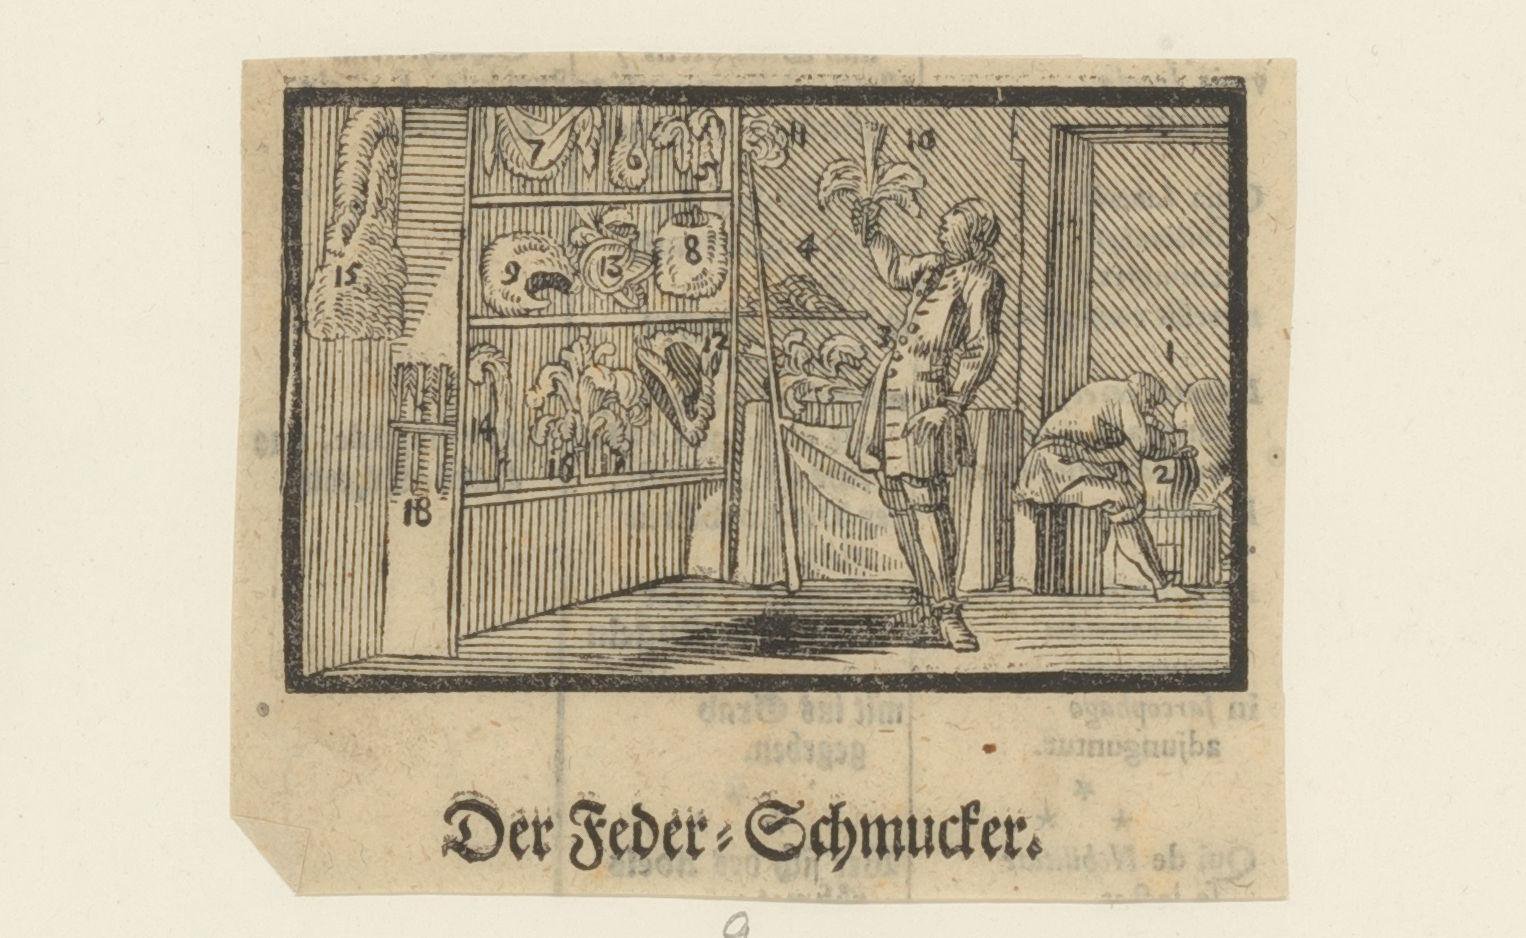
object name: print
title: Winkel voor veren en sieraden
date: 1719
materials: paper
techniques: letterpress printing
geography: nuremberg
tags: handicrafts, craftsman at work, making of feather attire, textile fabric, cloth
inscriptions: stamp, collector's mark: Lugt 1641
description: Prent uit: Comenius, Johannes Amosius. Orbis sensualium picti pars prima (...). Neurenberg: Martin Endter, 1719, dl. 2, p. 400. Prent eerder gebruikt in: Comenius, Johannes Amosius. Orbis Sensualium Picti denuo aucti Pars Secunda (...). Neurenberg: Martin Endter, 1730, dl. 2.